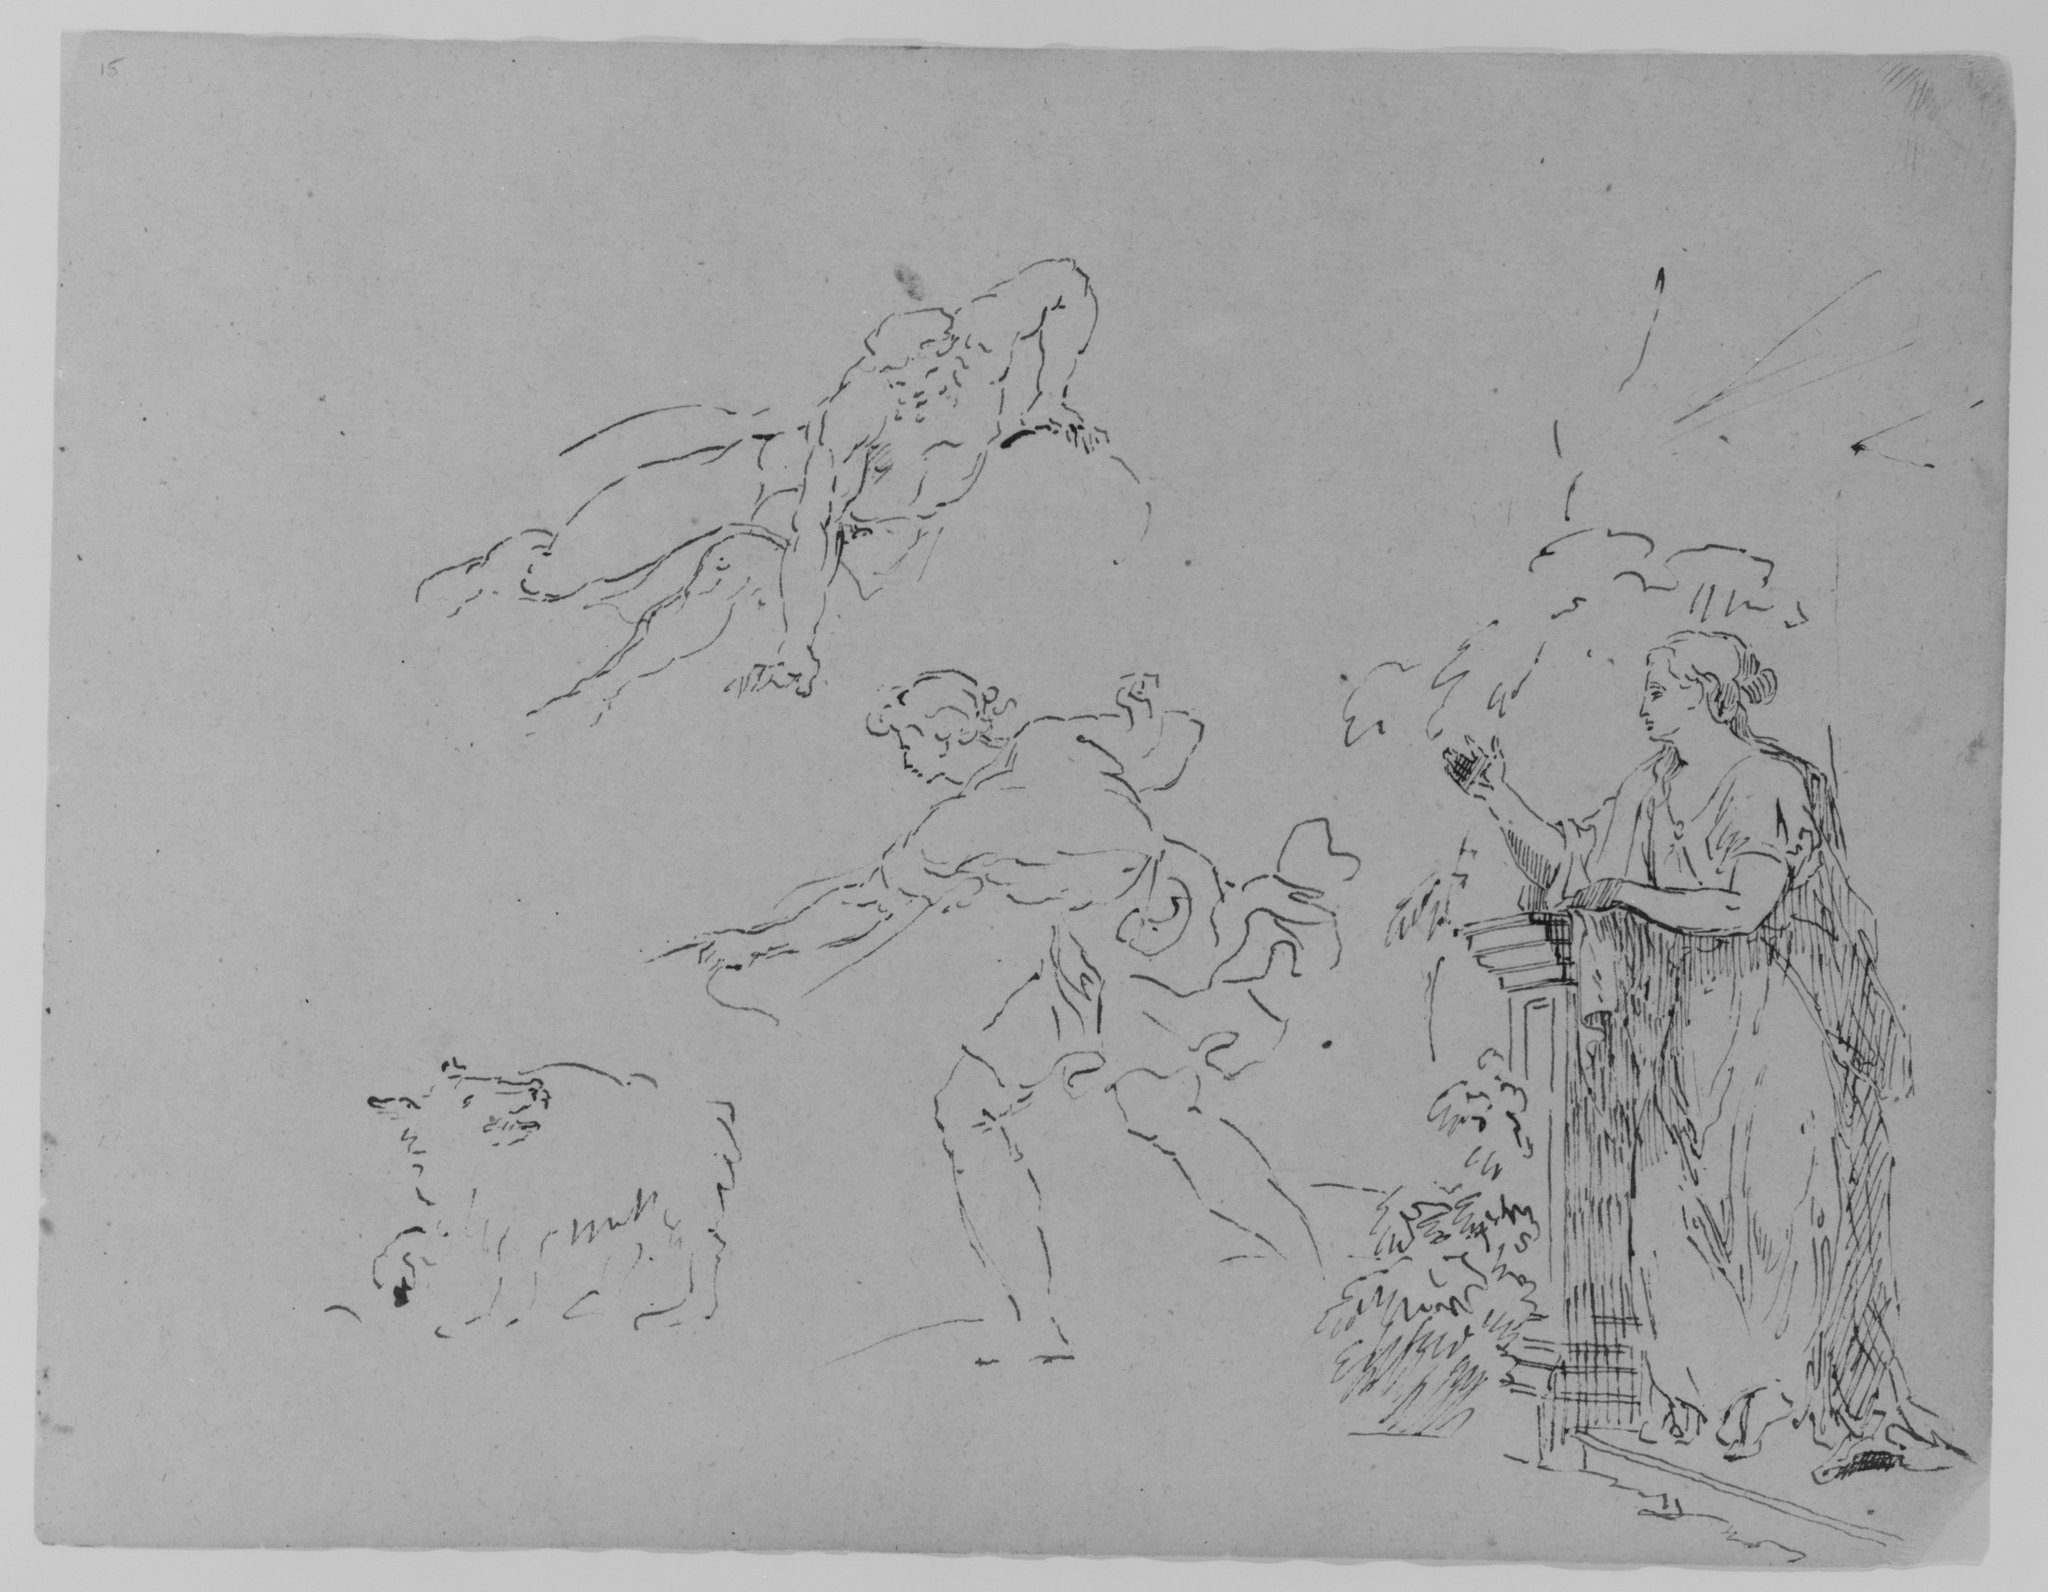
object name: drawing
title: Male [Breaking Fall]; Male Gesturing Toward Dog; Female on Step Leaning Against Column by Foliage (from Sketchbook)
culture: american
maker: thomas sully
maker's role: artist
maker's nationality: american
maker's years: 1783-1872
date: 1810-1820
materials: ink, paper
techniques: wash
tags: men,women,dogs